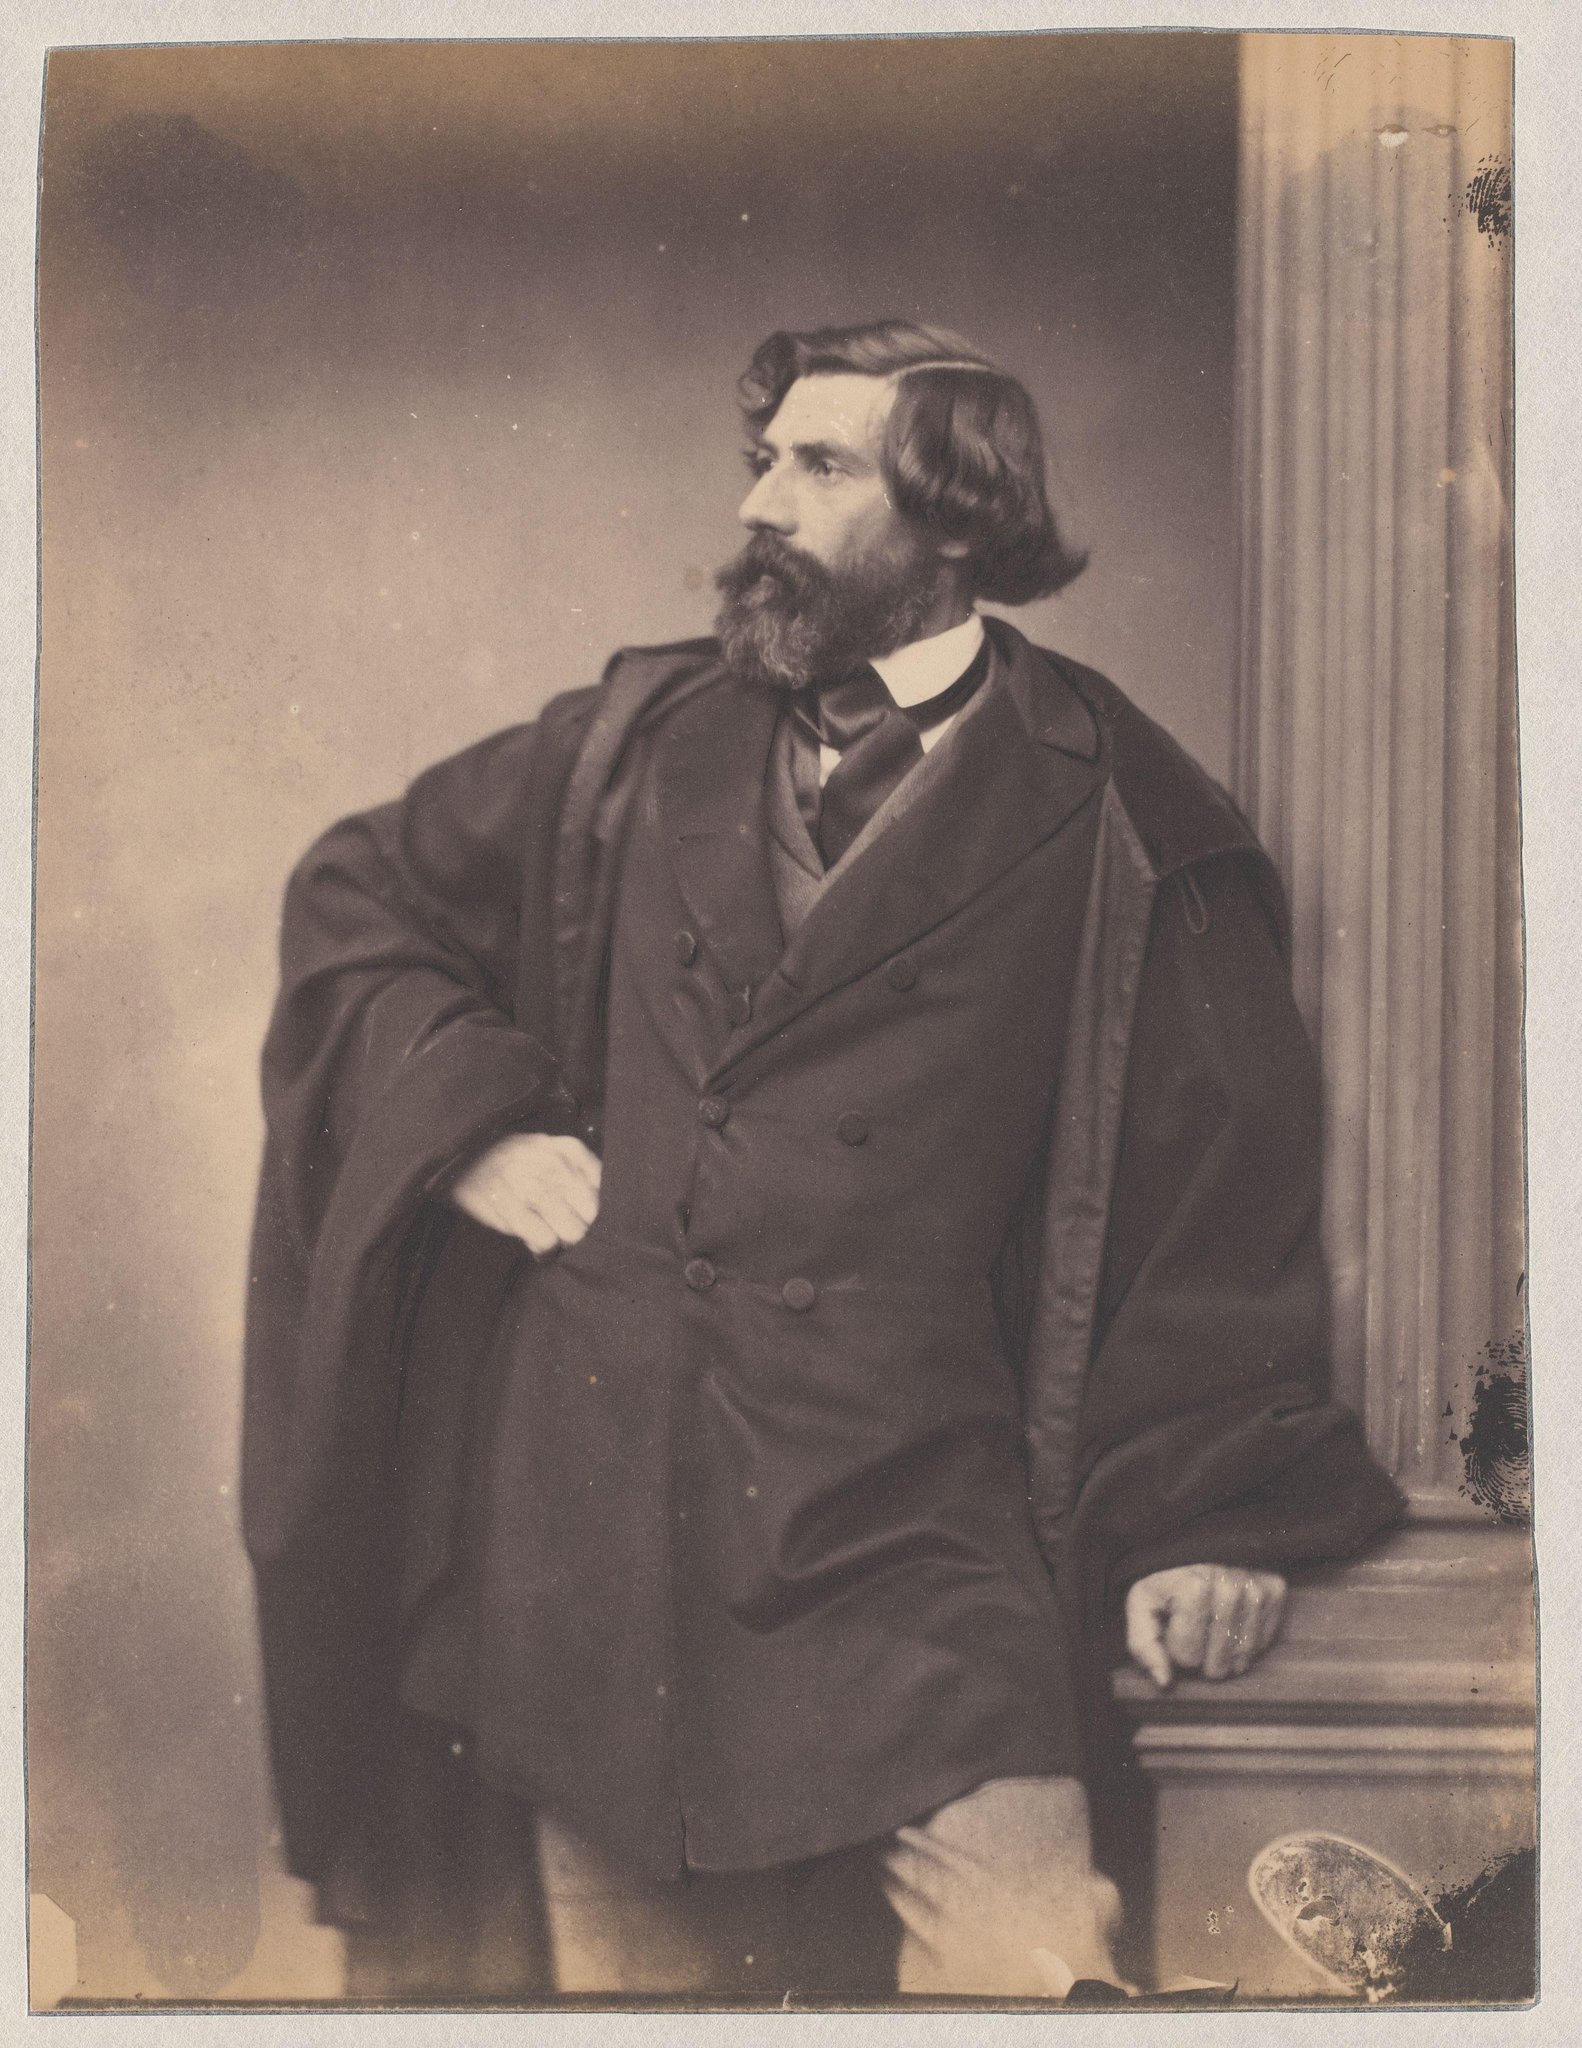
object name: photograph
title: Portret van Ludwig Lange, staand en leunend op een zuil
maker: franz seraph hanfstaengl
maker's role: painter, print maker, printer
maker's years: 1804-1877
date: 1855-1860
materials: paper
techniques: salted paper print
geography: germany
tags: ludwig lange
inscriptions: inscription: ‘Ludwig Lange’